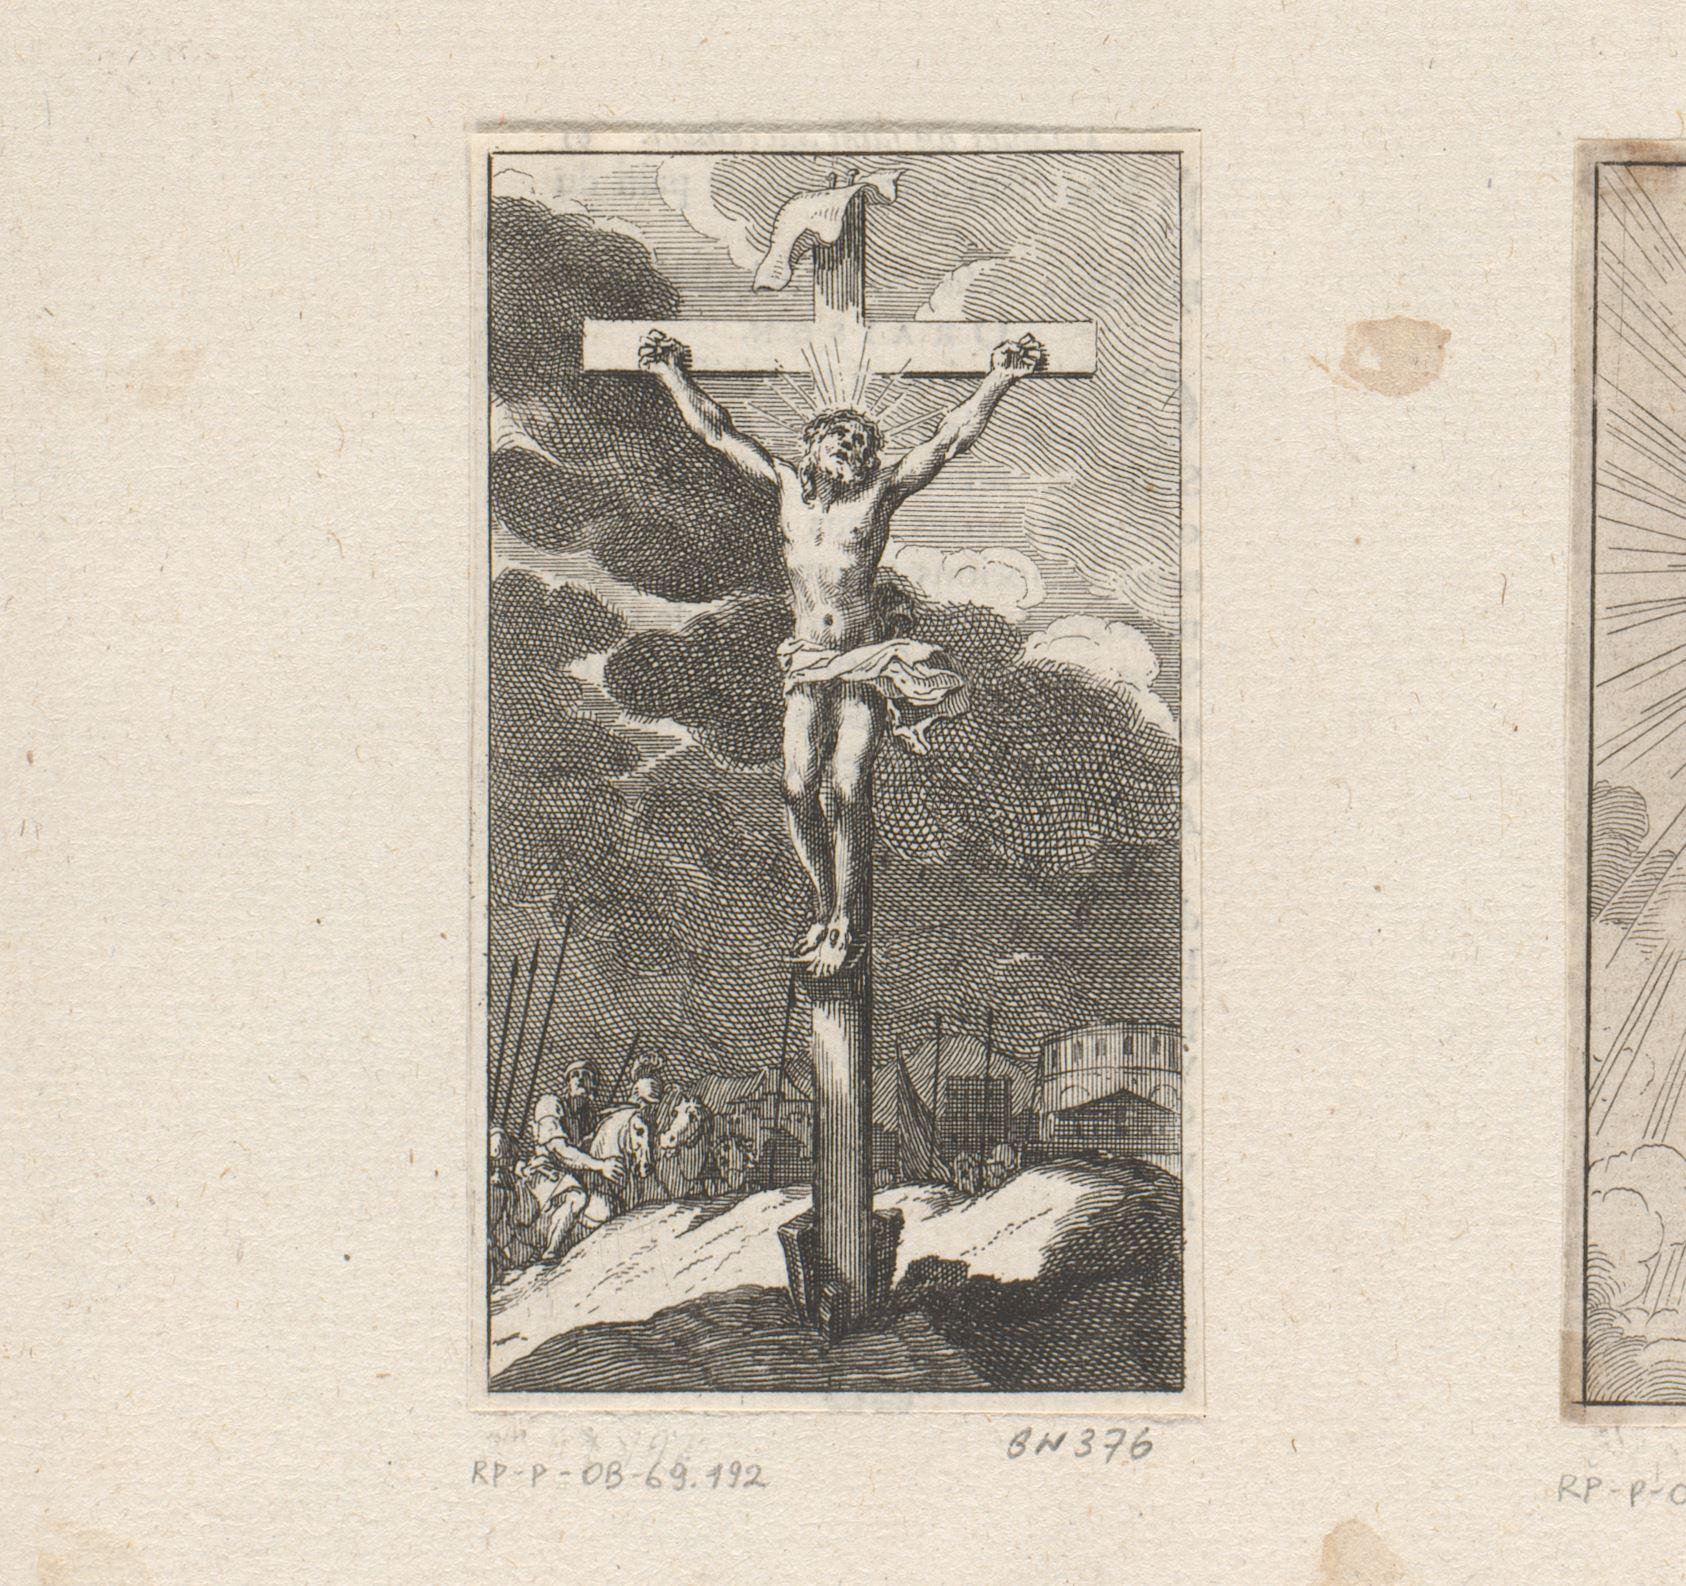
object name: print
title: Kruisiging van Christus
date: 1683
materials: paper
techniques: etching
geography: france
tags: the crucifixion of christ: christ's death on the cross; golgotha (matthew 27:45-58; mark 15:33-45; luke 23:44-52; john 19:25-38)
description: Prent uit: Heures dédiées à la Dauphine. Metz: François Bouchard, 1683.